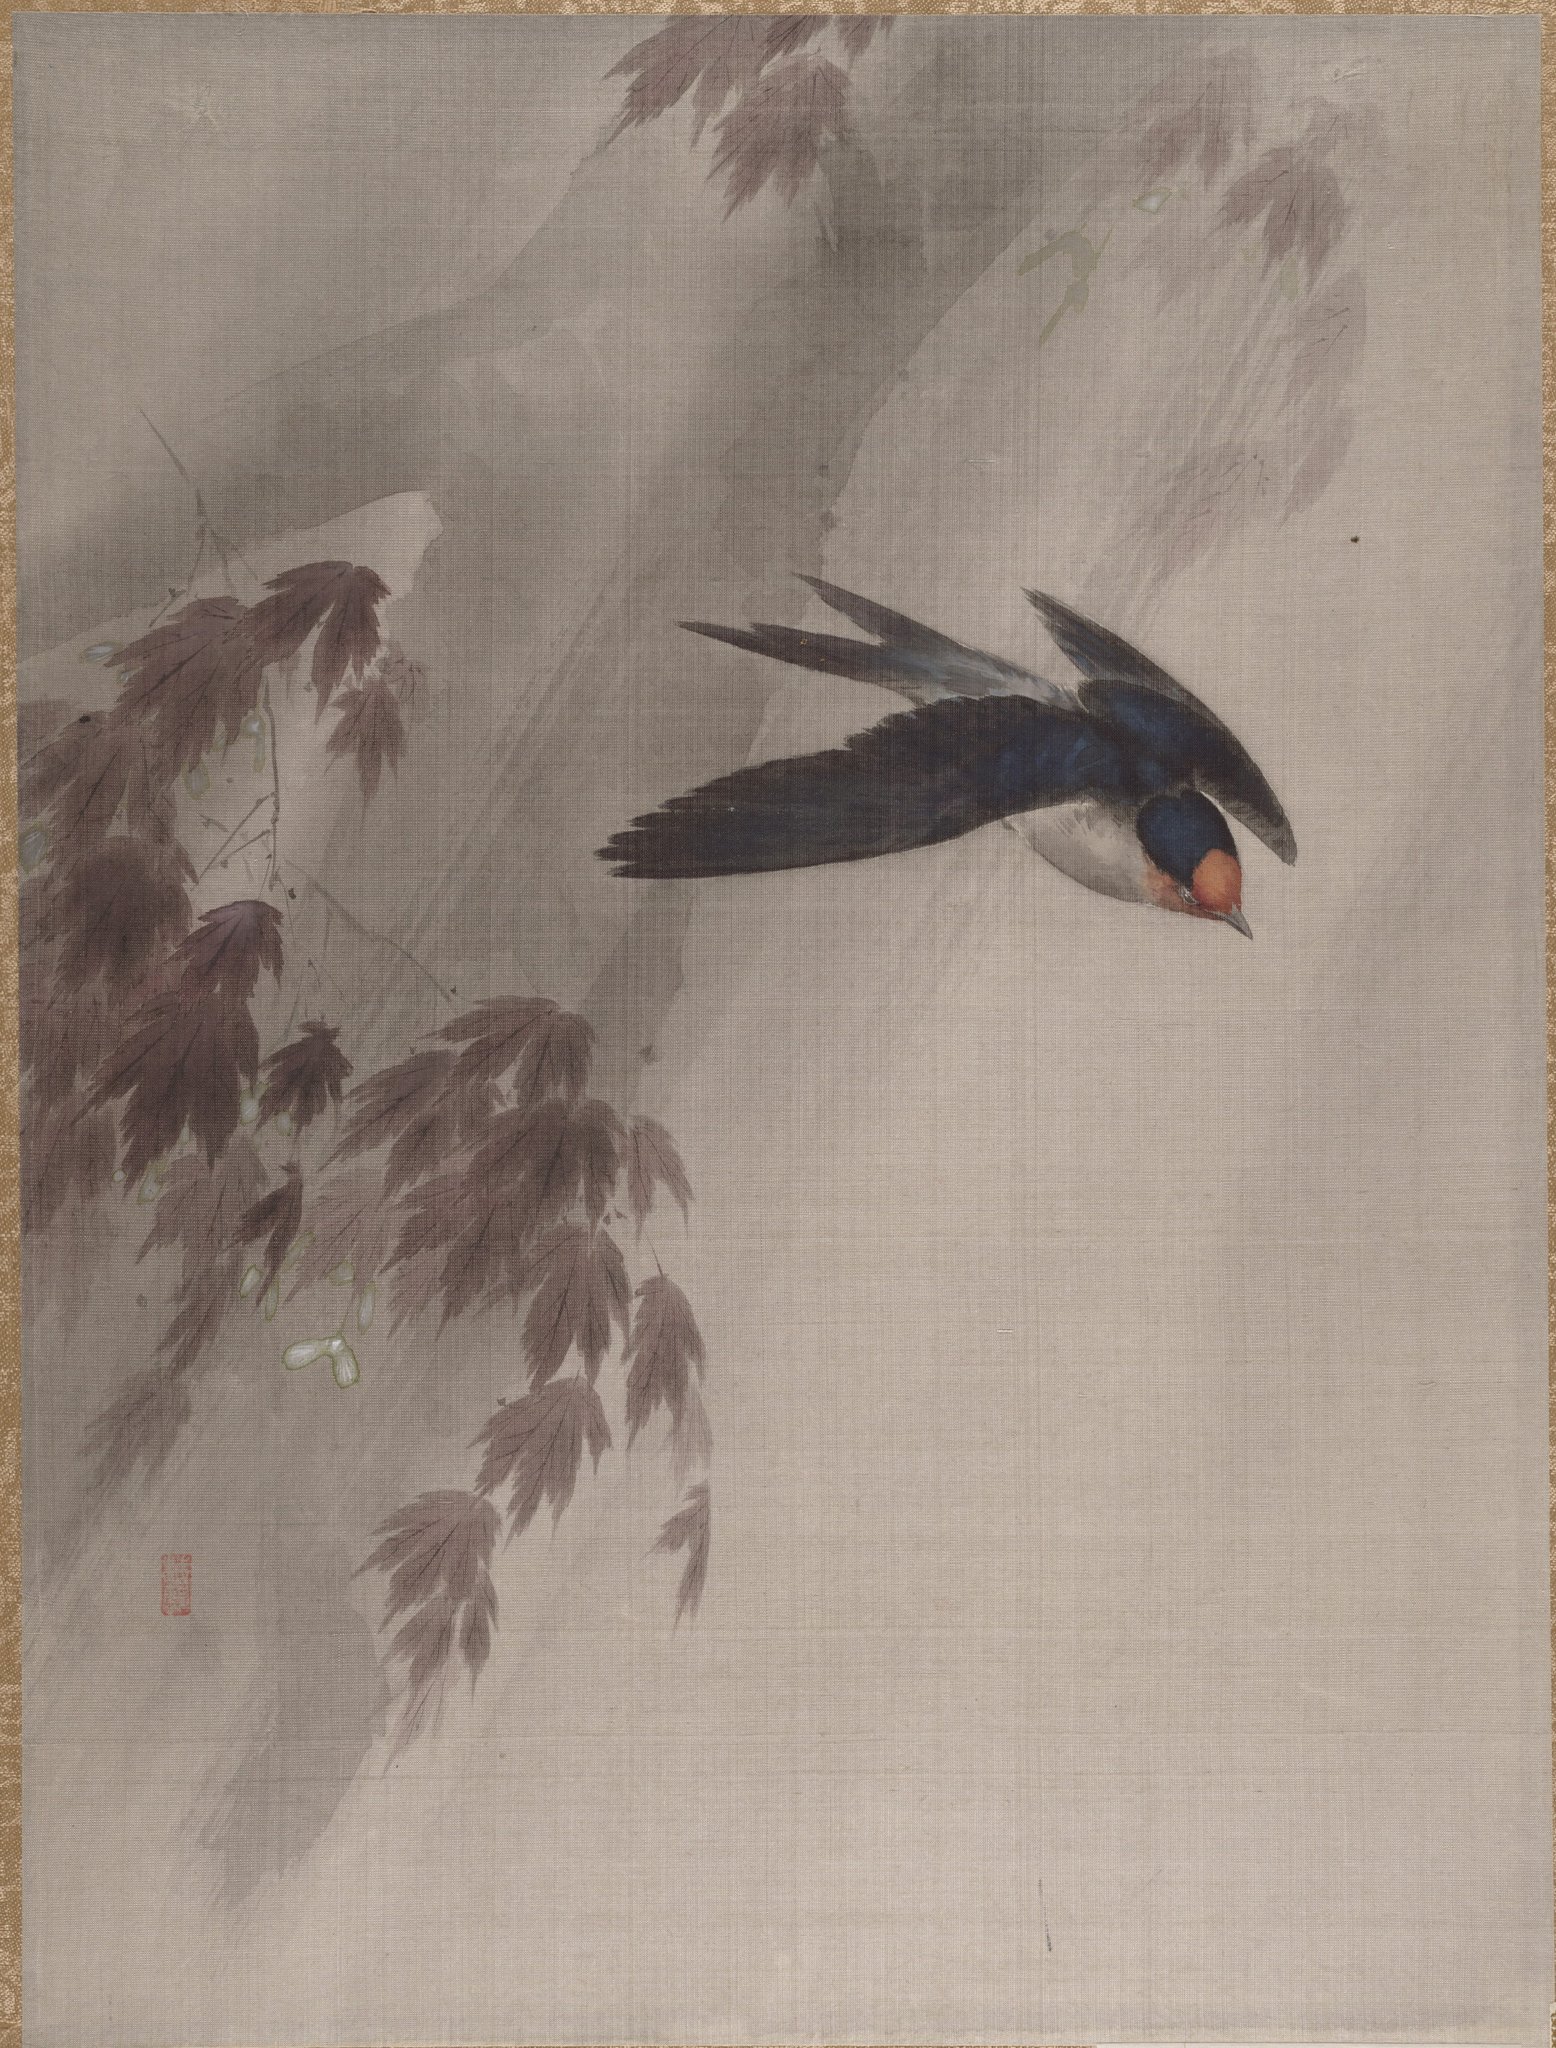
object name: album leaf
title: A Swallow in the Rain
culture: japanese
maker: okada baison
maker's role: artist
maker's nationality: japanese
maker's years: 1864-1913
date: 1891-1892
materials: ink, silk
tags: birds